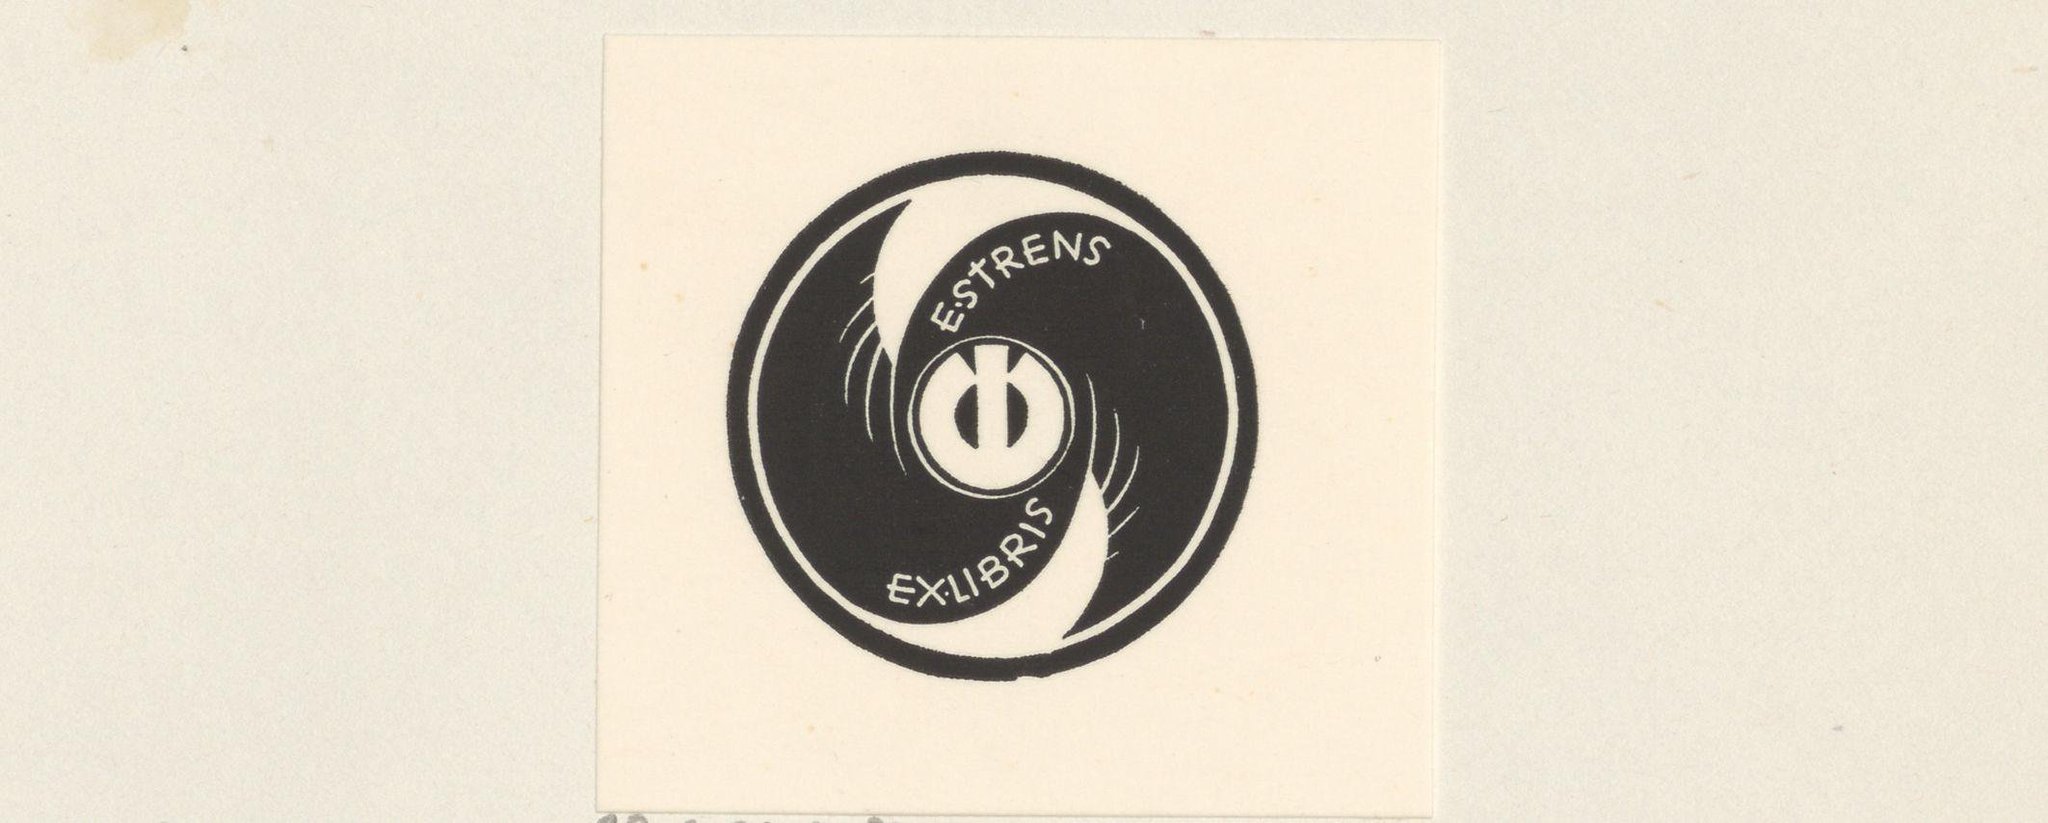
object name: bookplate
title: Exlibris/ E. Strens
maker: karl haselböck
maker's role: print maker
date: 1934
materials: paper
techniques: engraving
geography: vienna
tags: eugène louis charles marie strens, gramophone record, disc, compact disc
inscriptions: workshop stamp: ‘Karl Haselböck 1934’